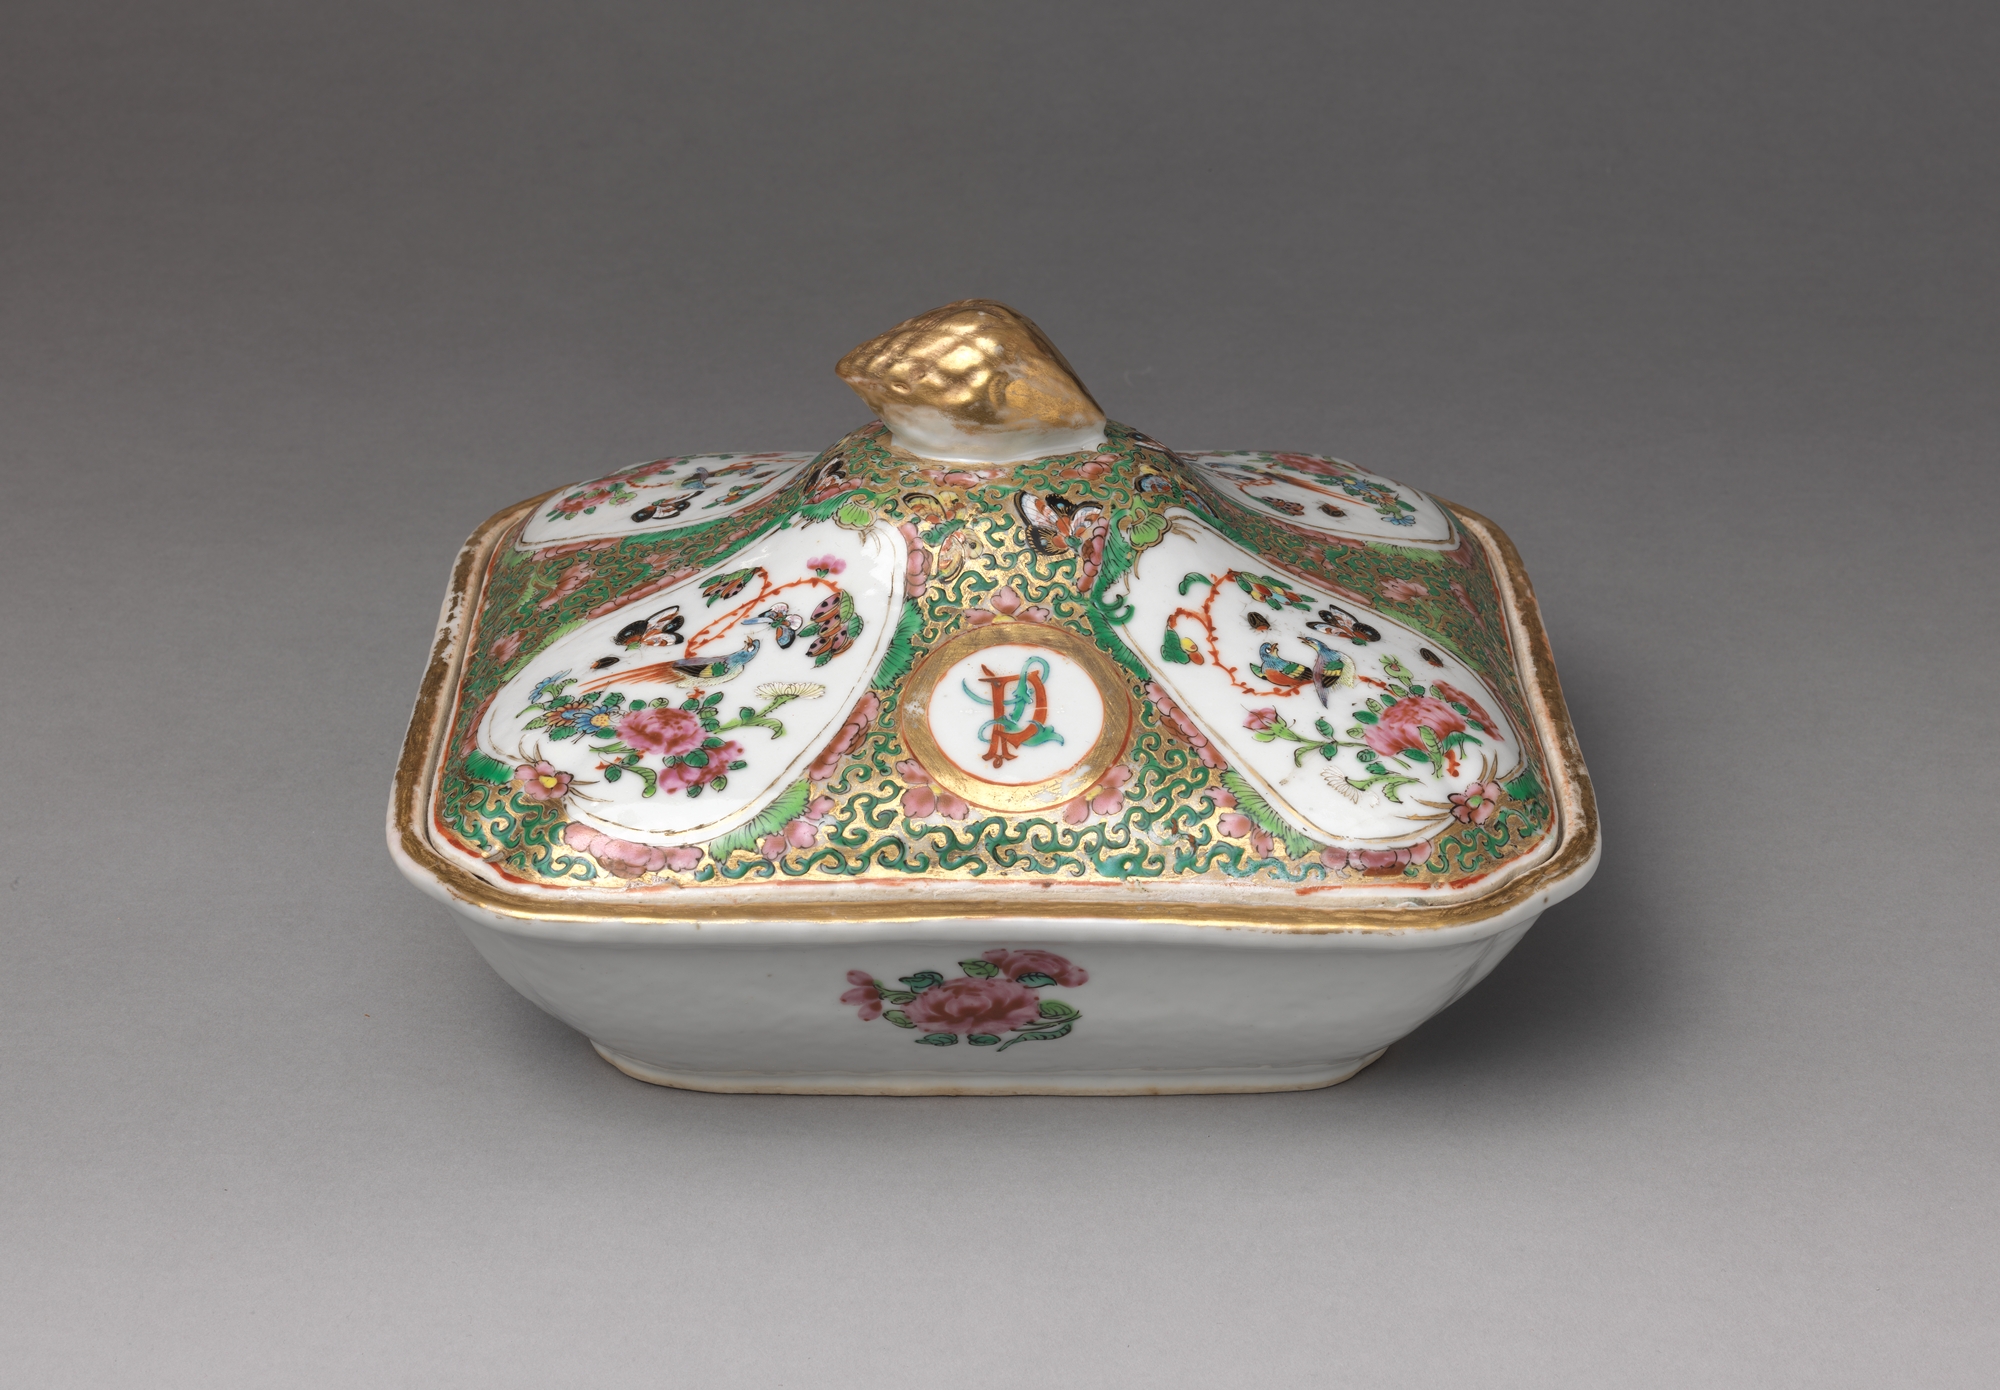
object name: serving dish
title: Covered Serving Dish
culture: chinese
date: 1860-1866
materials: porcelain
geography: china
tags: birds,butterflies,flowers